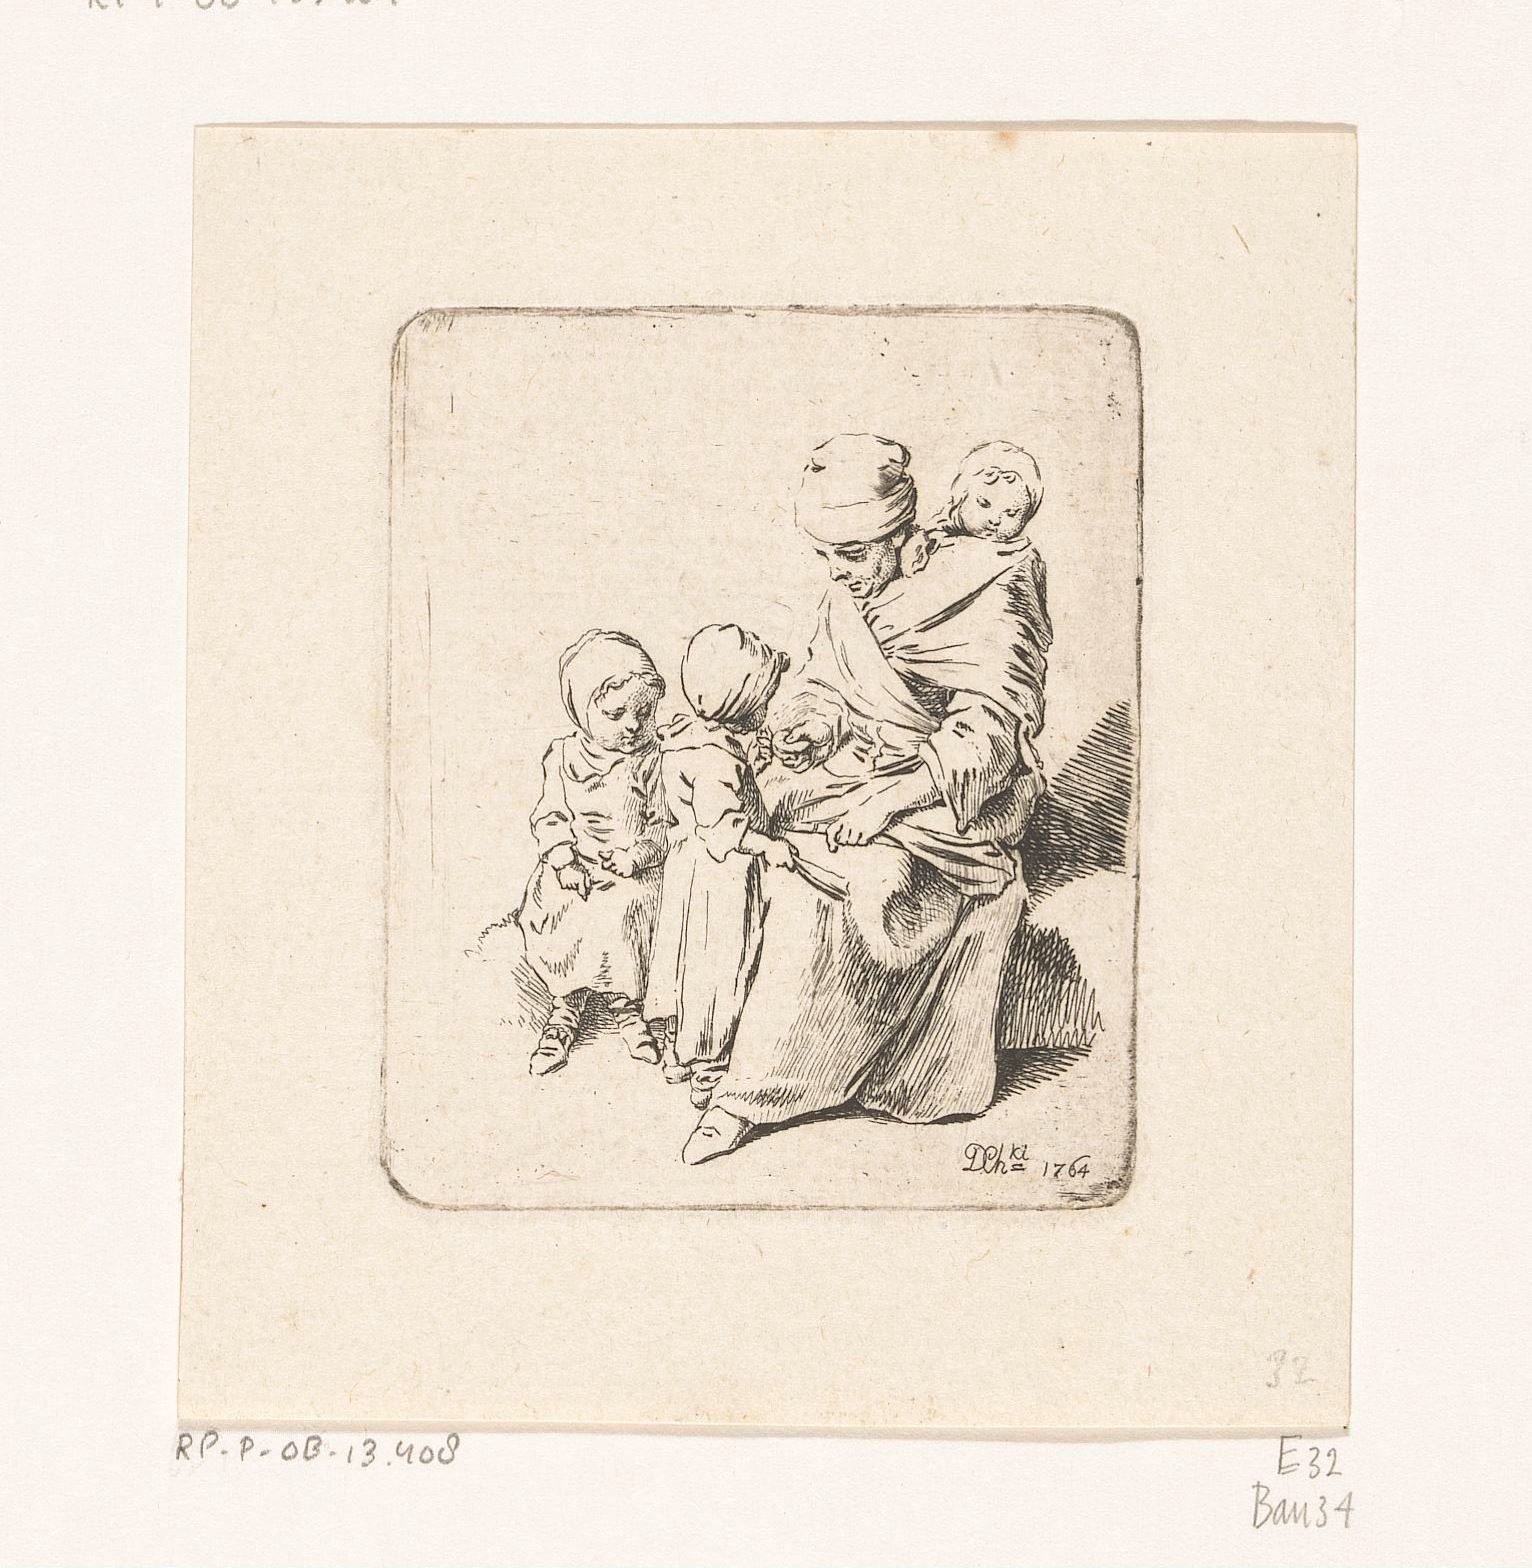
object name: print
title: Bedelares met drie kinderen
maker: daniel nikolaus chodowiecki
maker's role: draughtsman, print maker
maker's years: 1726-1801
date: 1764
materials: paper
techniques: etching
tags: beggar, mother and child(ren), woman and child(ren) (family group)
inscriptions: collector's mark: Lugt 2228